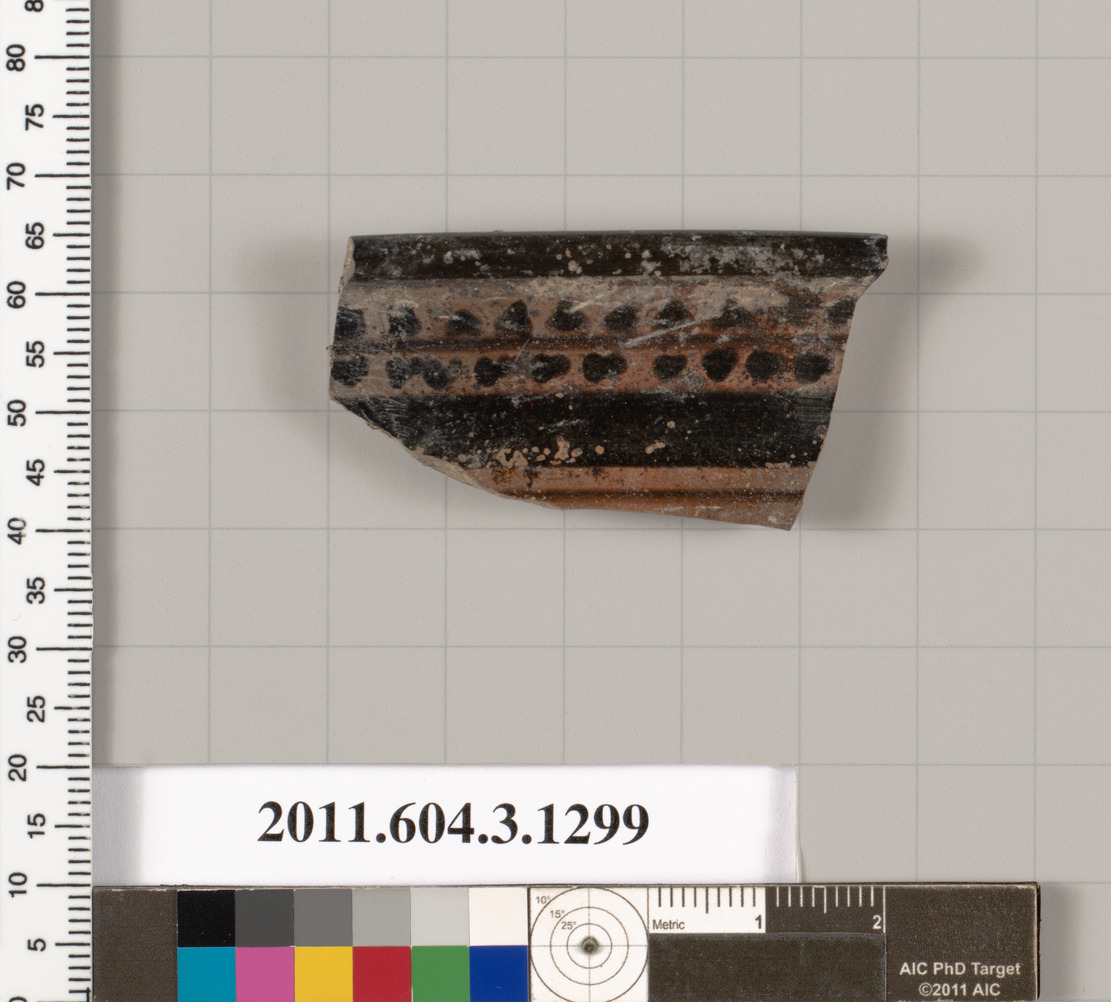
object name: skyphos fragment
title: Terracotta rim fragment of a skyphos (deep drinking cup)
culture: greek, attic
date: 534-468 BCE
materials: terracotta